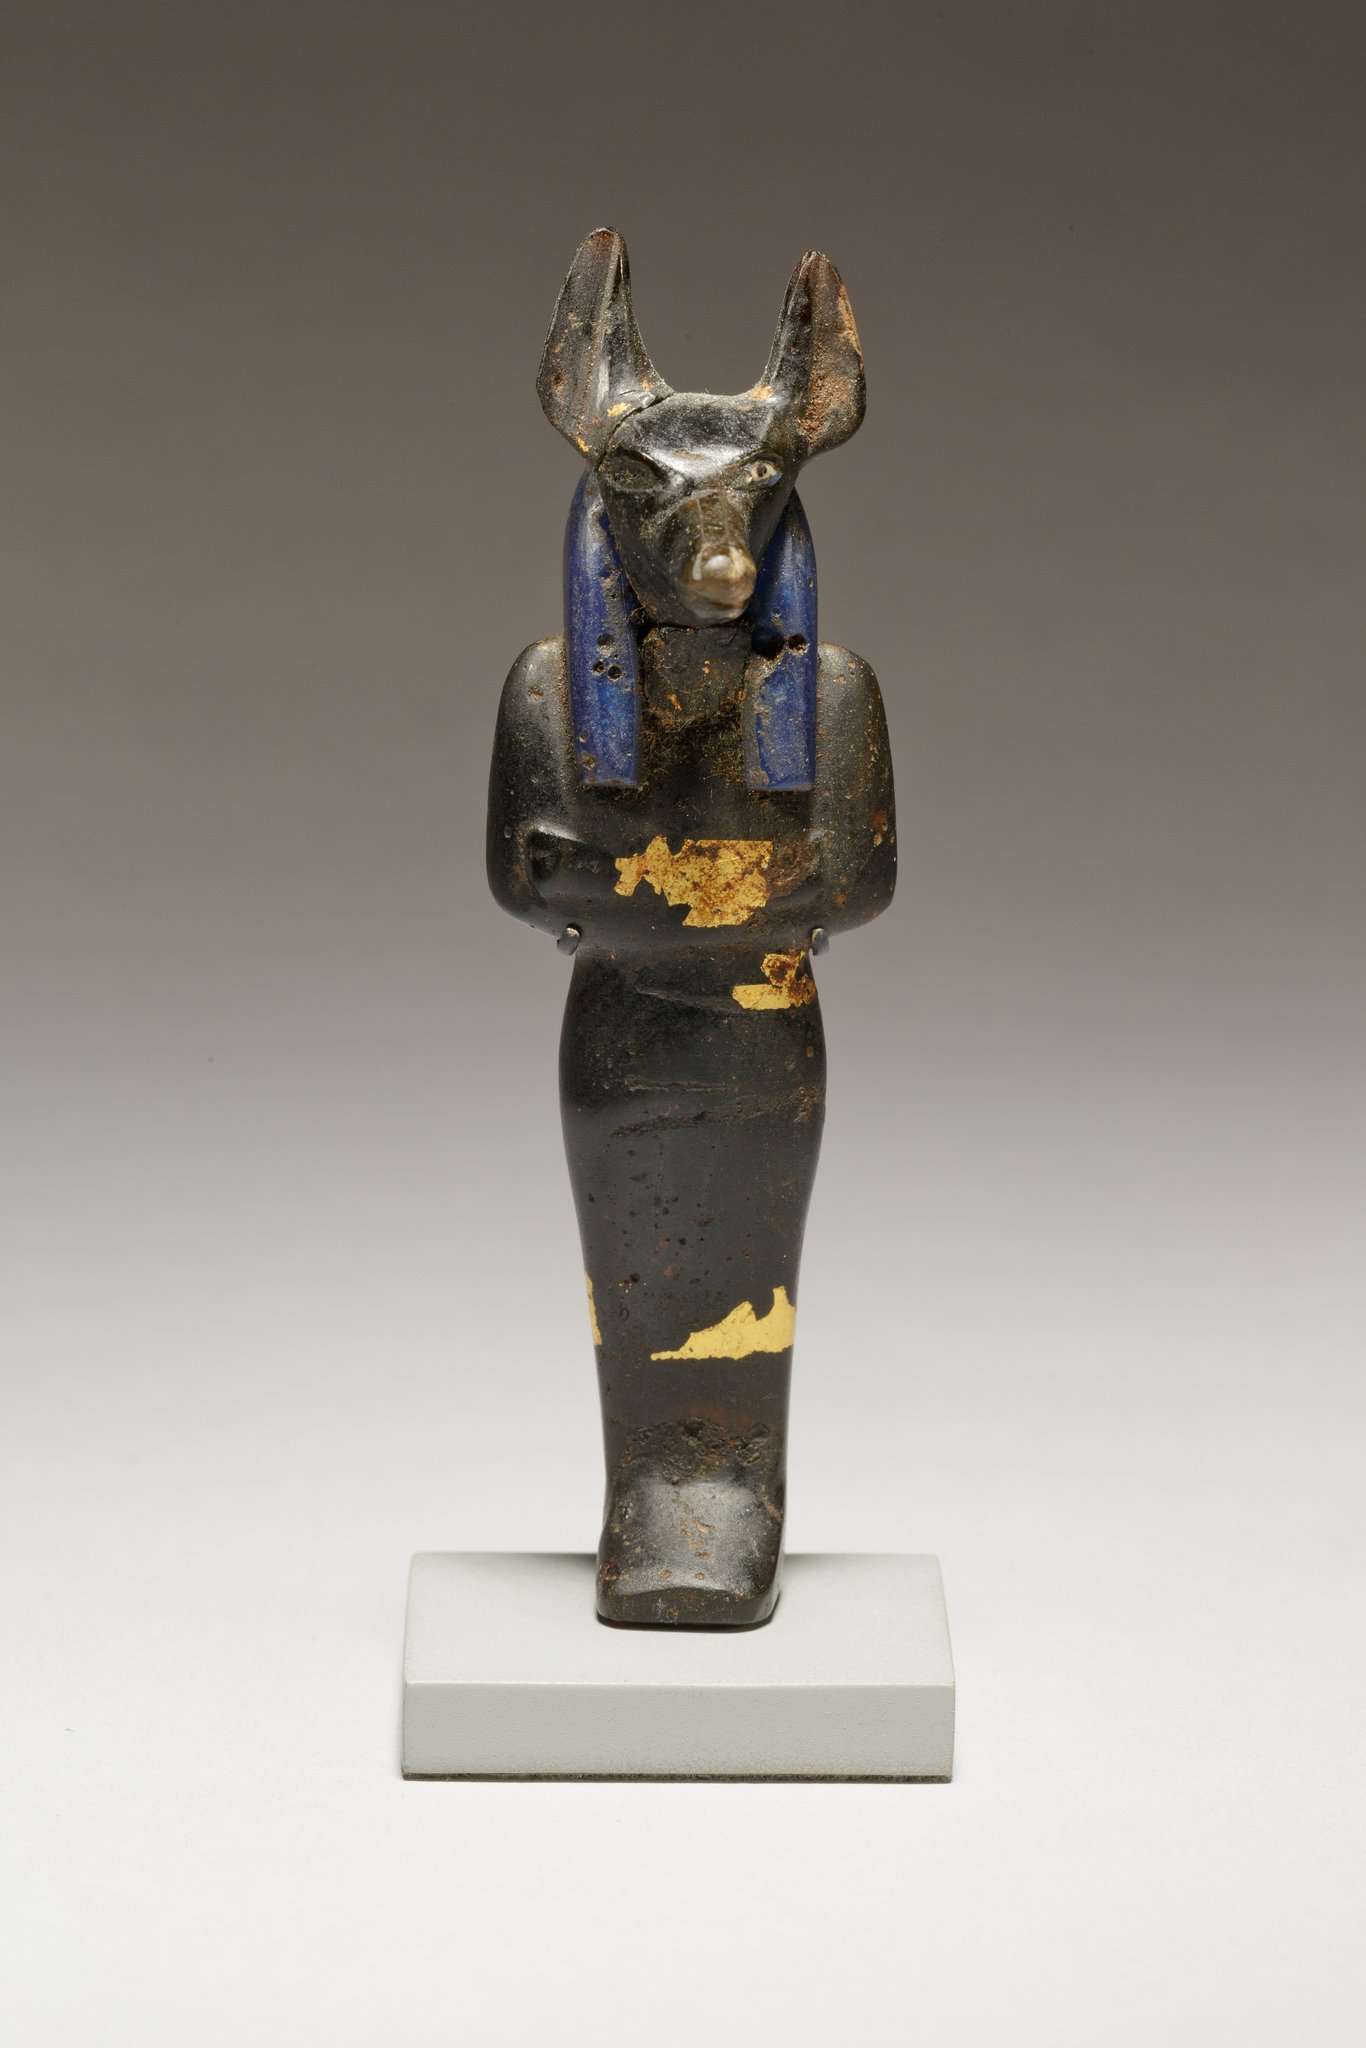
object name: funerary figure, duamutef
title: Funerary figure of Duamutef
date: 1100-332 BCE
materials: glass, metal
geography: egypt